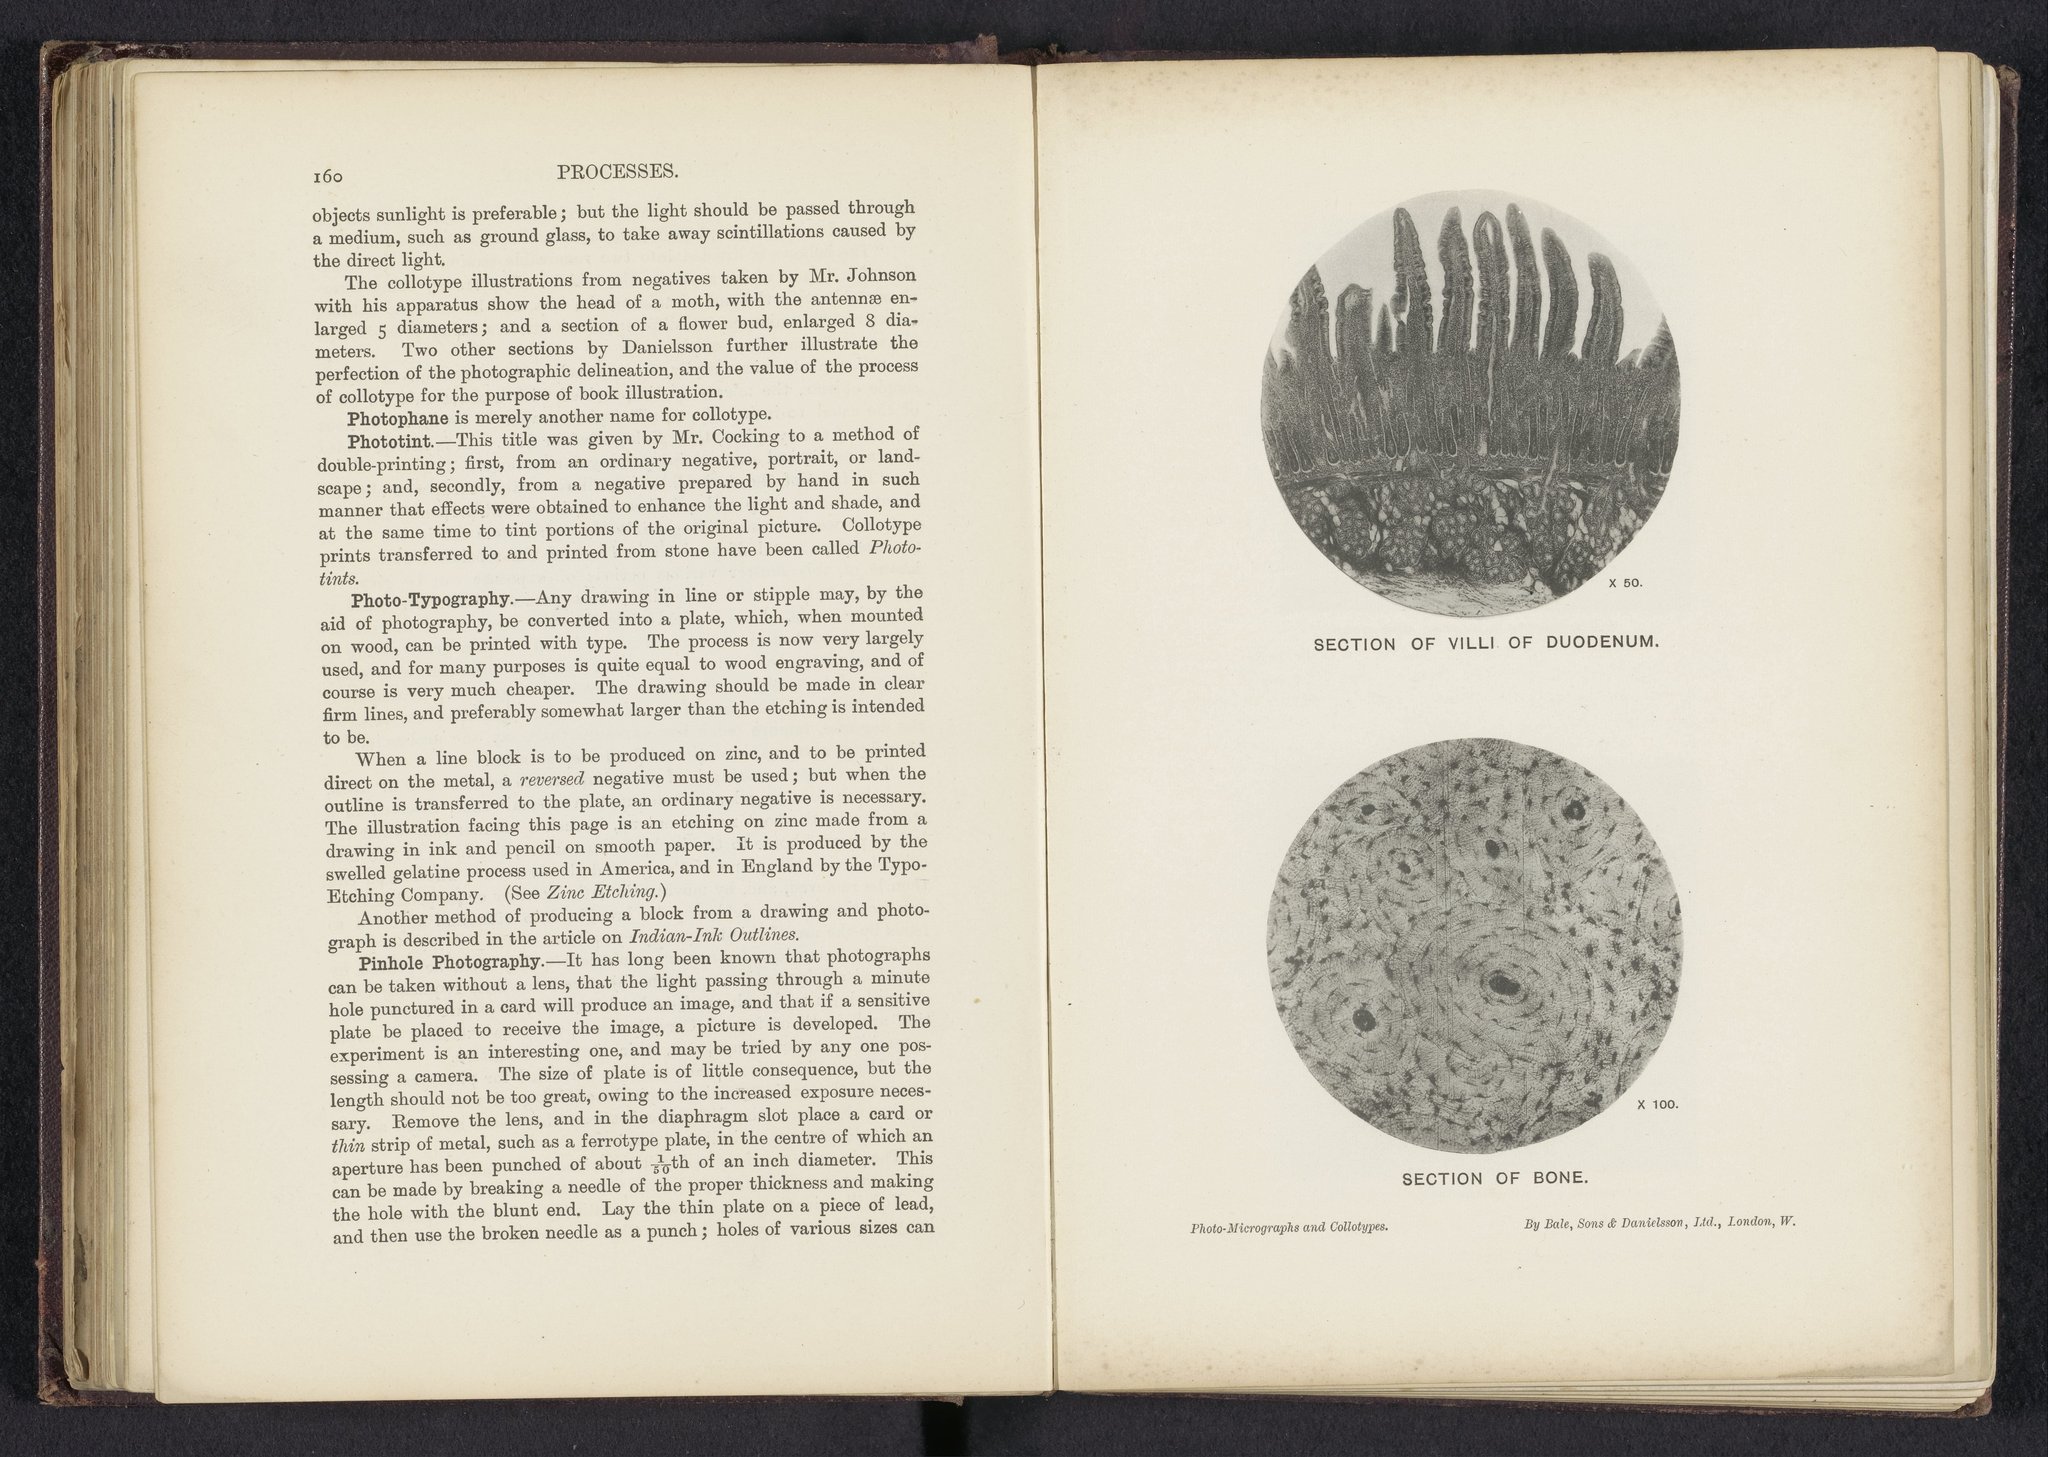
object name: photomechanical print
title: Section of villi of duodenum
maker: Anonymous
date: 1889-1899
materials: paper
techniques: photograph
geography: london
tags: intestines, bones in general (human body)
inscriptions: inscription: ‘x 50. x 100.’